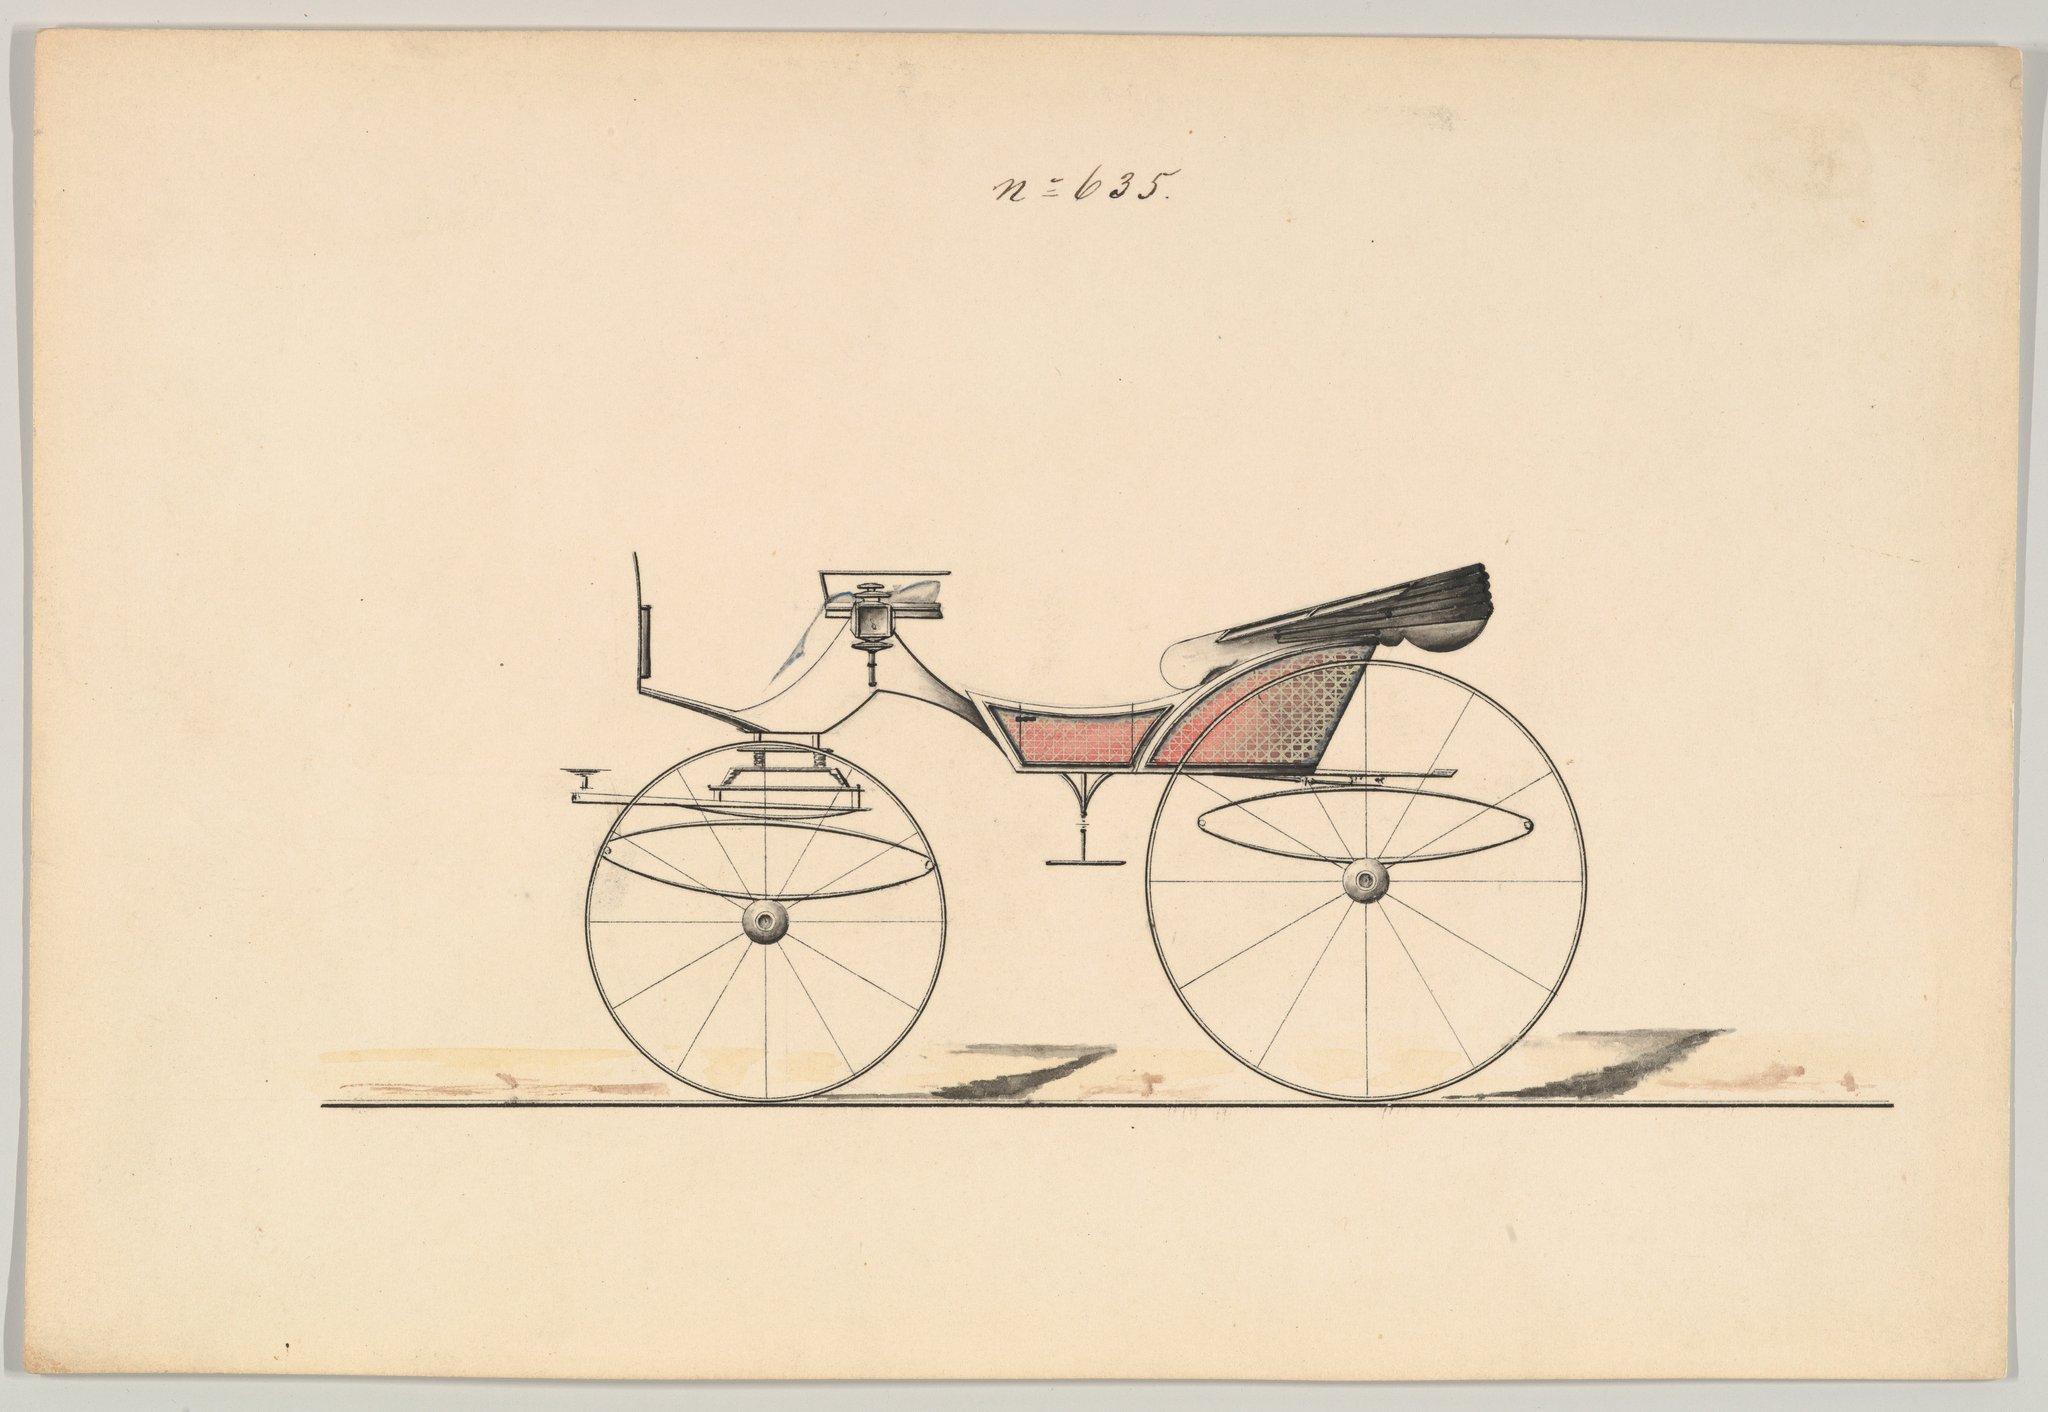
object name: drawing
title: Design for Phaeton, no. 635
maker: brewster & co.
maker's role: manufacturer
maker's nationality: american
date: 1850-1870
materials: gouache, ink, watercolor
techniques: pen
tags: carriages